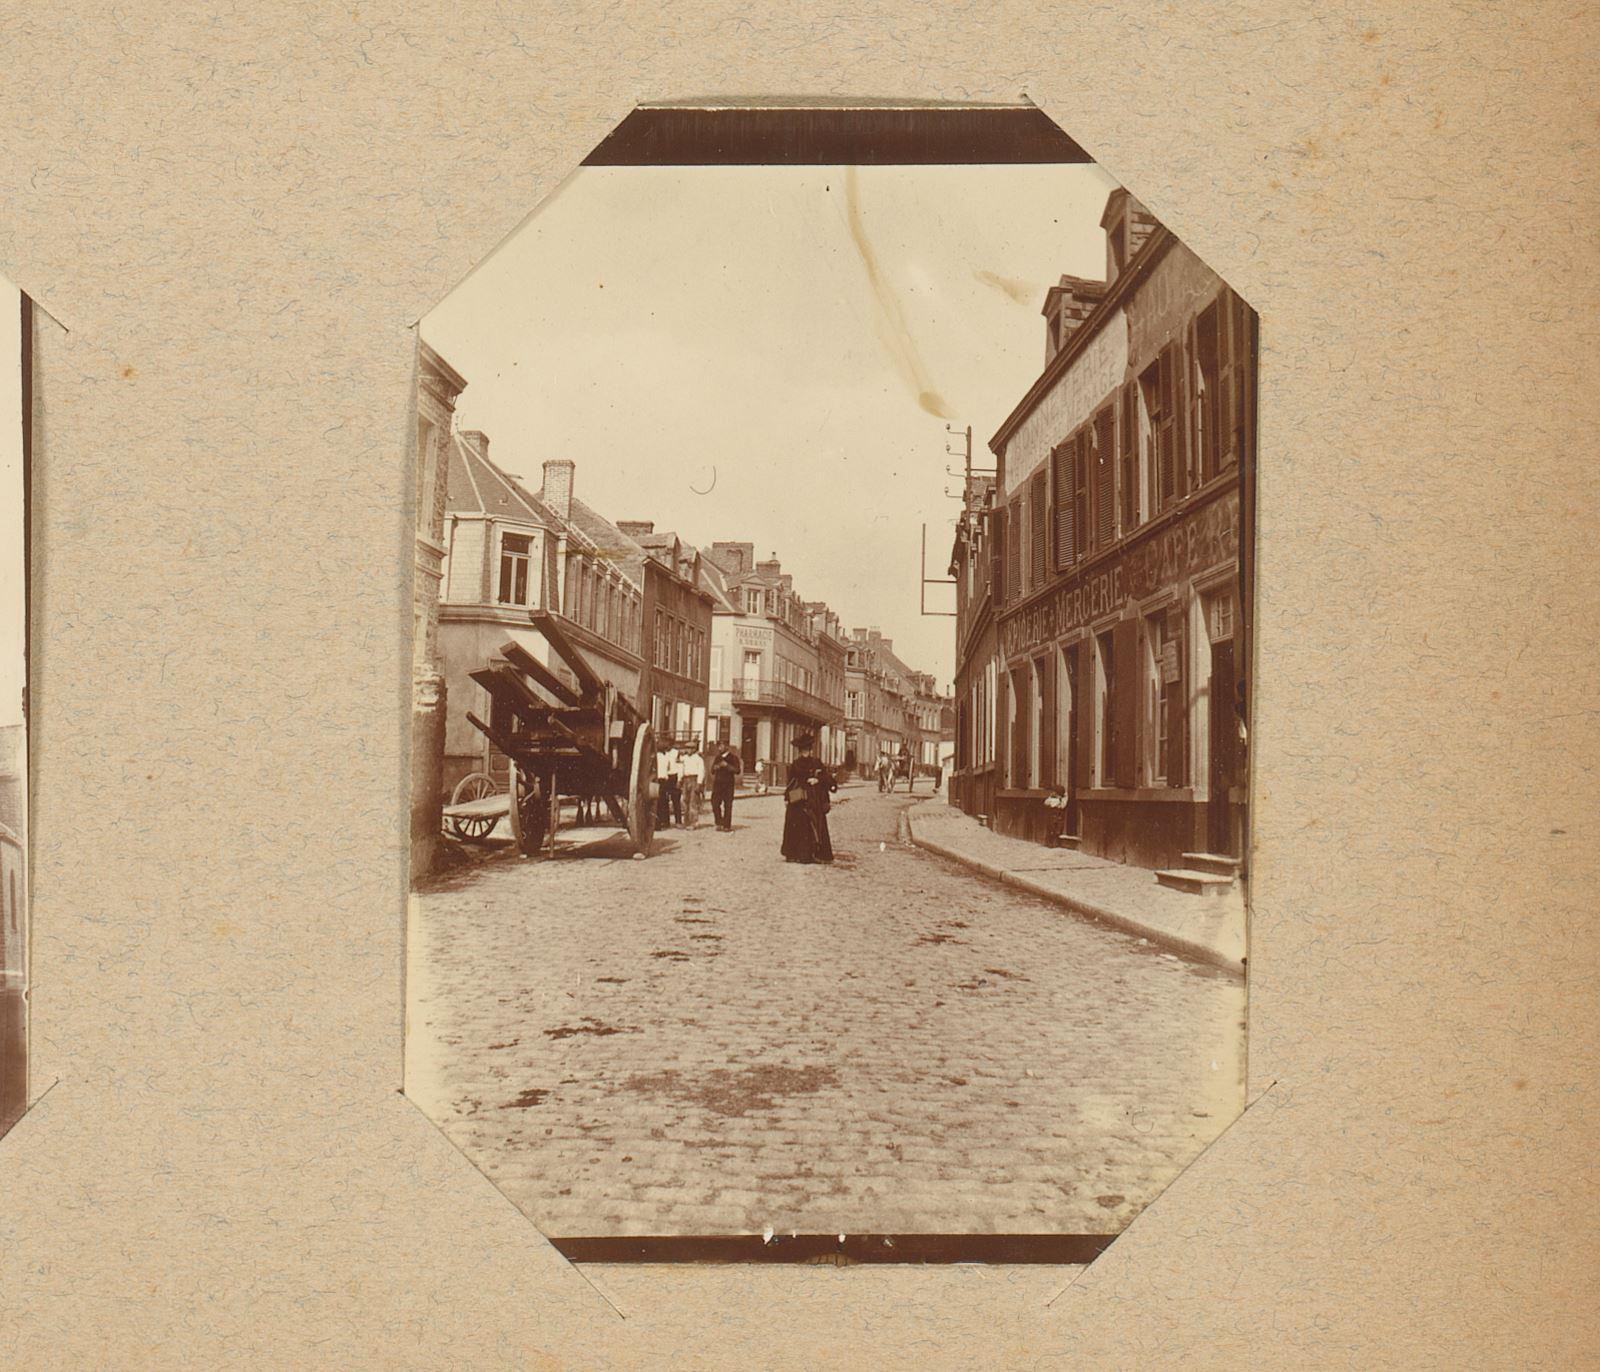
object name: album leaf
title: Straatgezicht in kleine stad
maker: Anonymous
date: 1897-1900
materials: paper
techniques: gelatin silver print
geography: france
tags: street, france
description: Over de foto is een ander negatief afgedrukt van een voorstelling van bomen.